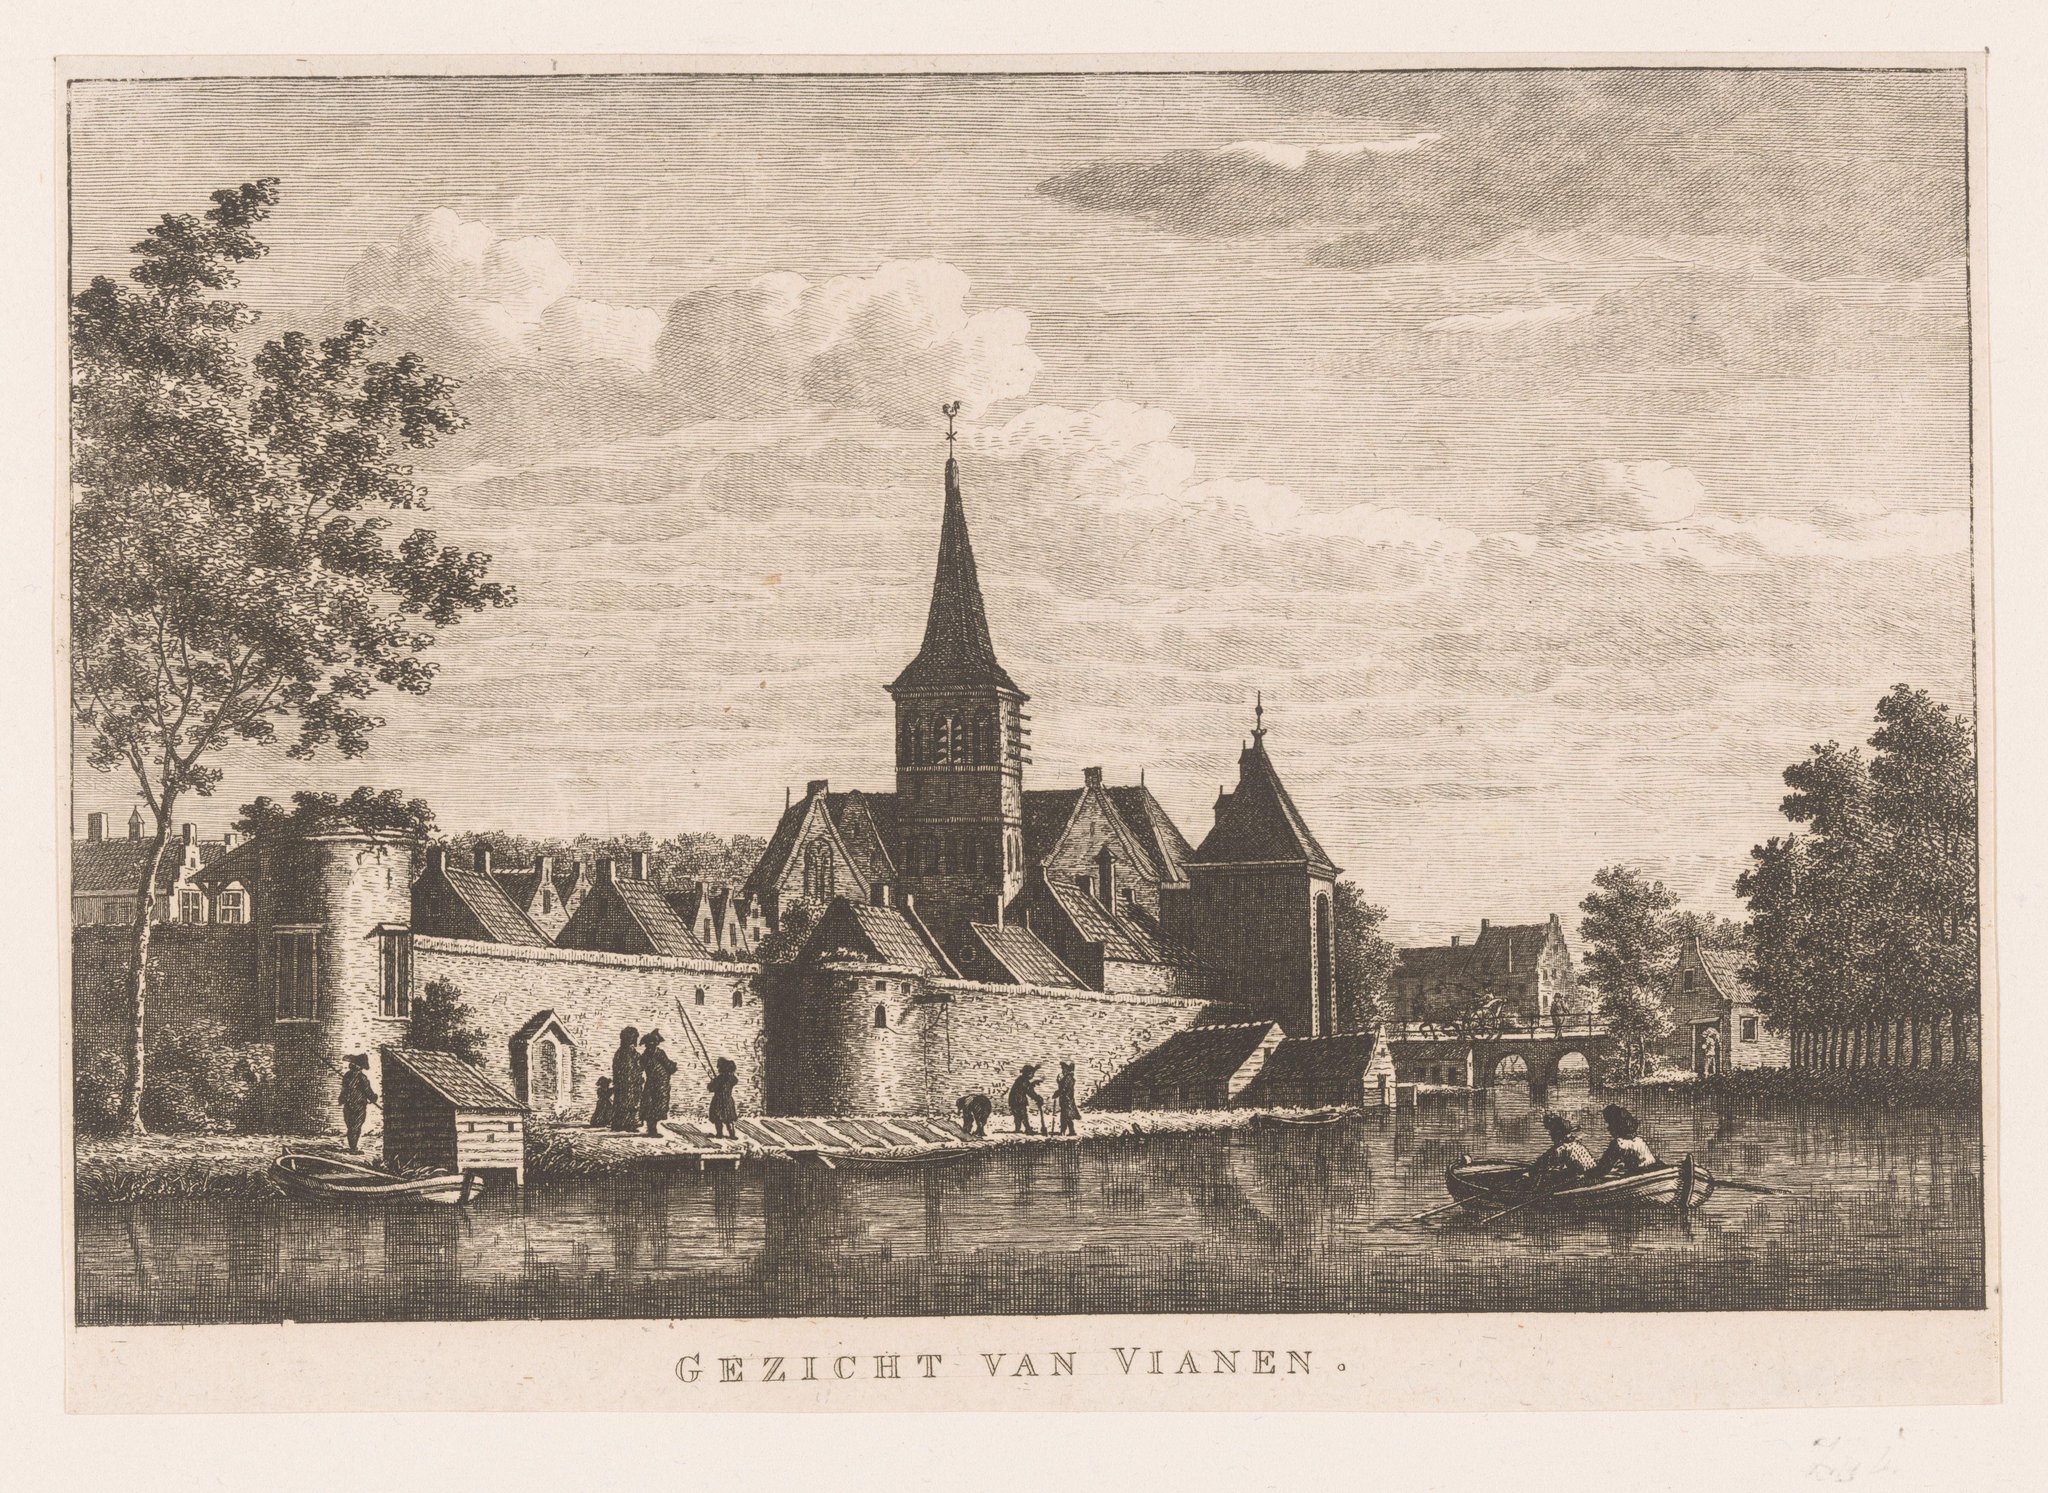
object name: print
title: Gezicht van Vianen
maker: carel frederik bendorp (i)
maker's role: print maker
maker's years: 1736-1814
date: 1786-1792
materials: paper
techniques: etching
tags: city-view, and landscape with man-made constructions, city-gate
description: Eerdere staat van prent gebruikt in: Vaderlandsche gezichten, of afbeeldingen van den tegenwoordigen staat der Vereenigde Nederlanden (…). Amsterdam: Hendrik Gartman, Willem Vermandel en Jan Willem Smit, 1786-1792. Uitgegeven in afleveringen met ieder een eigen bifolium en inhoudsopgave. Alle prenten in deze publicatie zijn gegraveerd door Carel Frederik Bendorp (I) en, in de meeste gevallen, gebaseerd op tekeningen van Jan Bulthuis.